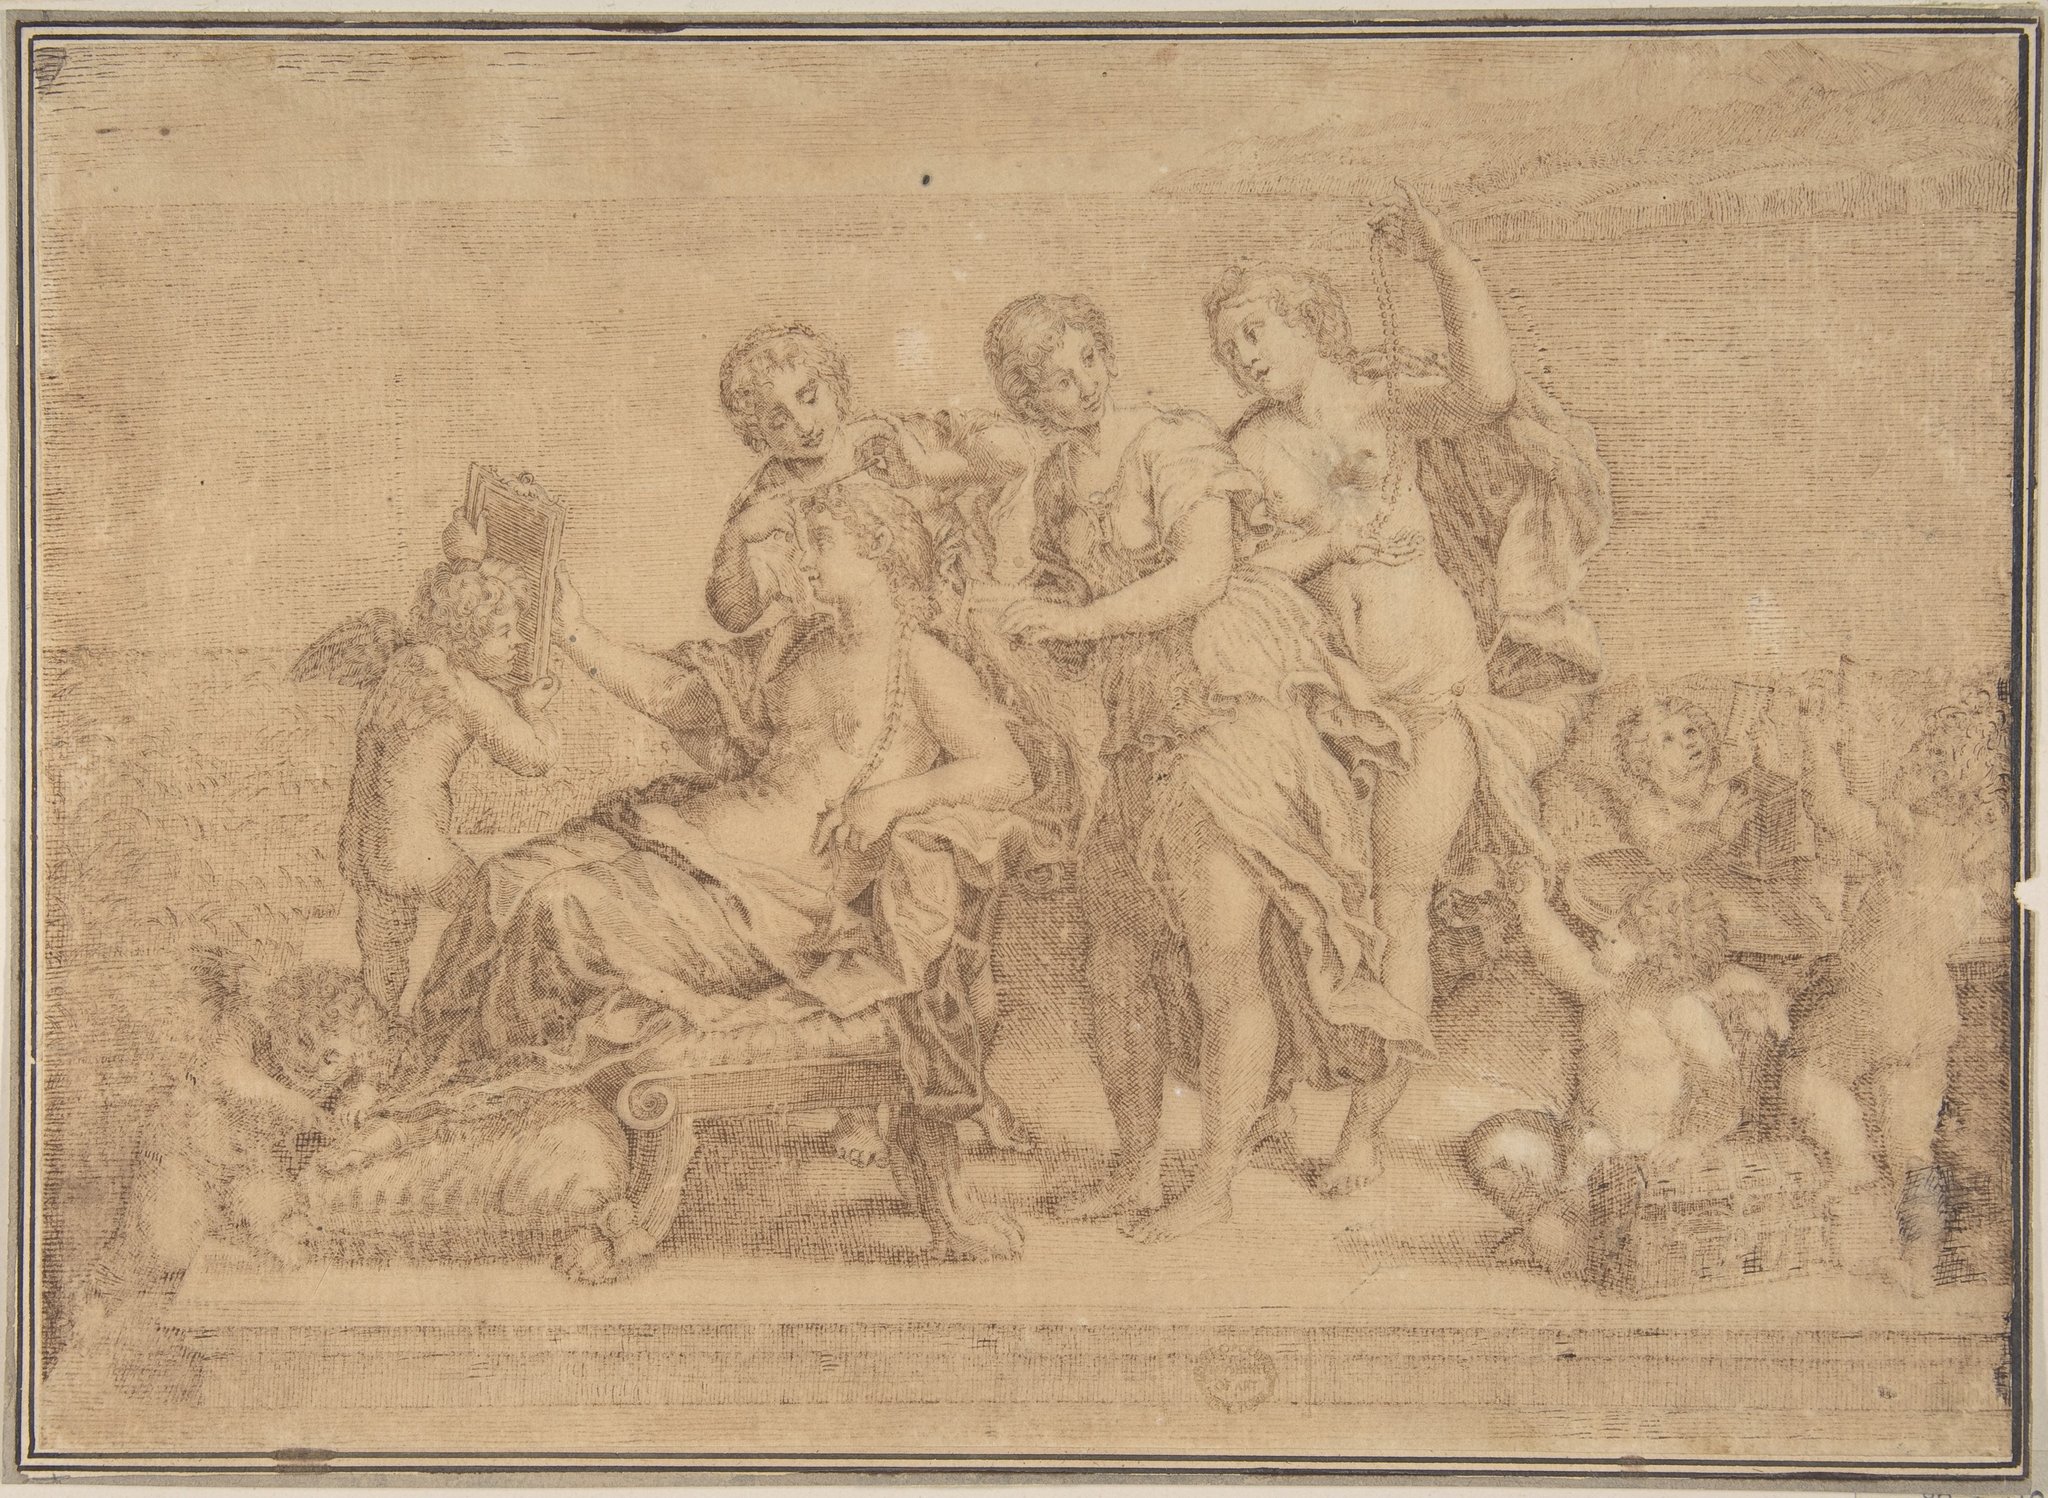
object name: drawing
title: Engraver's Copy After The Toilet of Venus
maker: francesco albani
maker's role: artist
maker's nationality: italian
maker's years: 1578-1660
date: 1601-1700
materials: ink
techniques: pen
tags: women,cupid,putti,venus